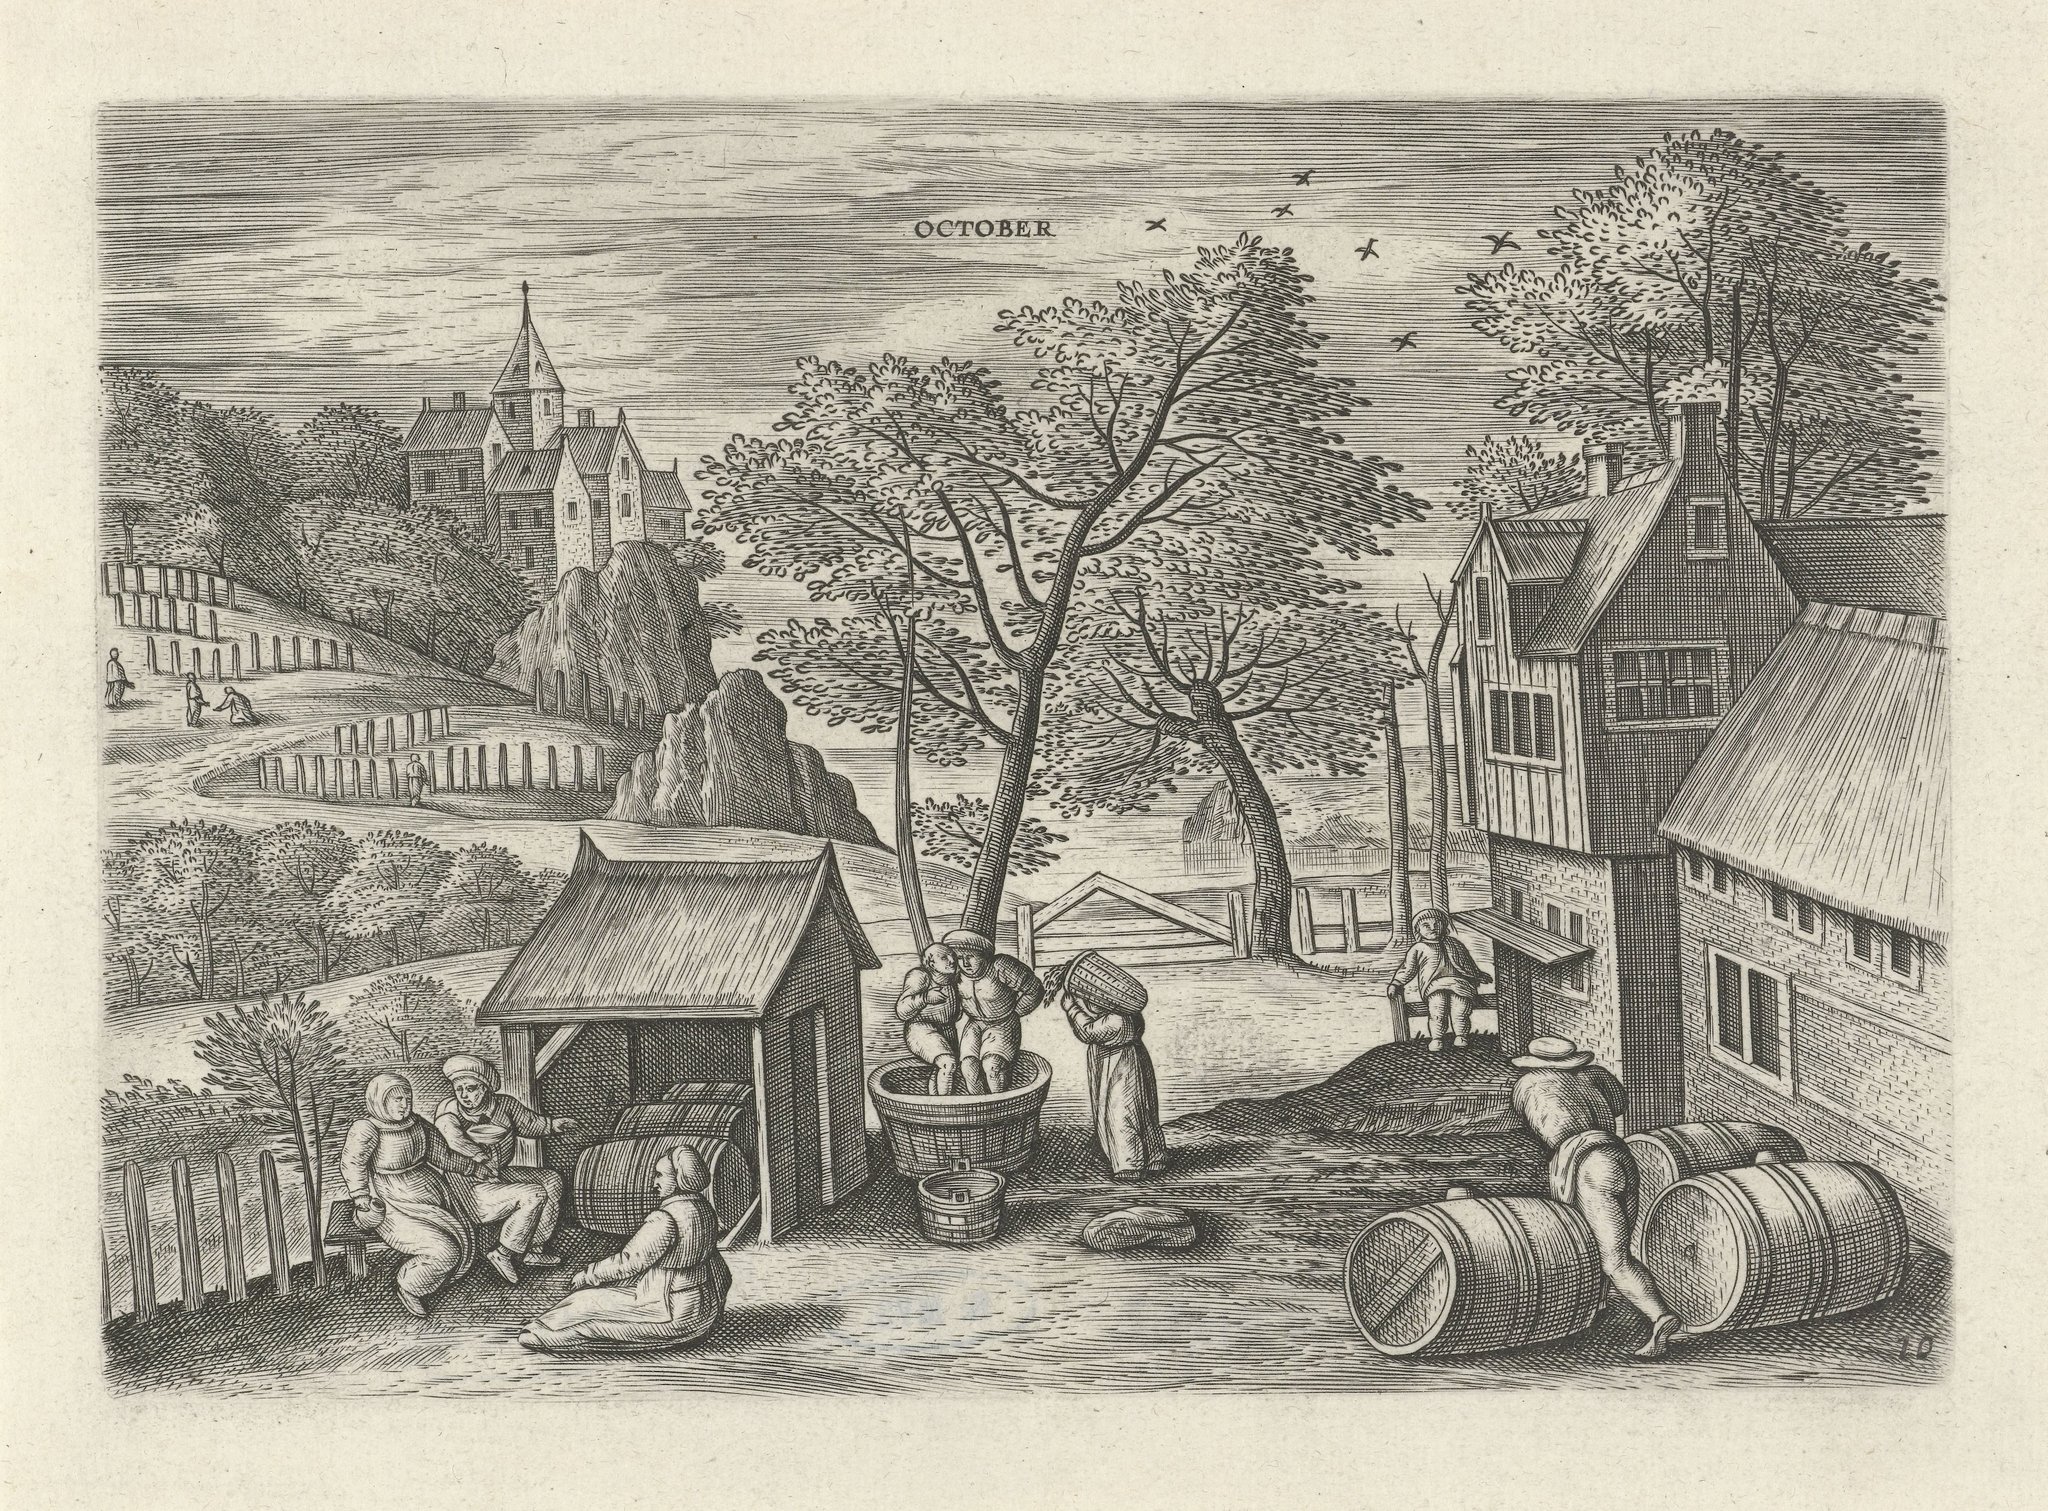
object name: print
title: Oktober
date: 1596-1652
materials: paper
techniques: engraving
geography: amsterdam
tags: october and its 'labours', treading grapes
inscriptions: collector's mark: Lugt 2228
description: Herfstlandschap met najaarstaferelen. Oktober is de wijnmaand. In het midden mannen, vrouwen en kinderen die druiven plukken en persen. Daarna worden de tonnen weggebracht. Deel van een serie van de twaalf maanden, waarbij elke maand wordt afgebeeld met de voor haar typerende menselijke activiteiten en haar klimatologische kenmerken.